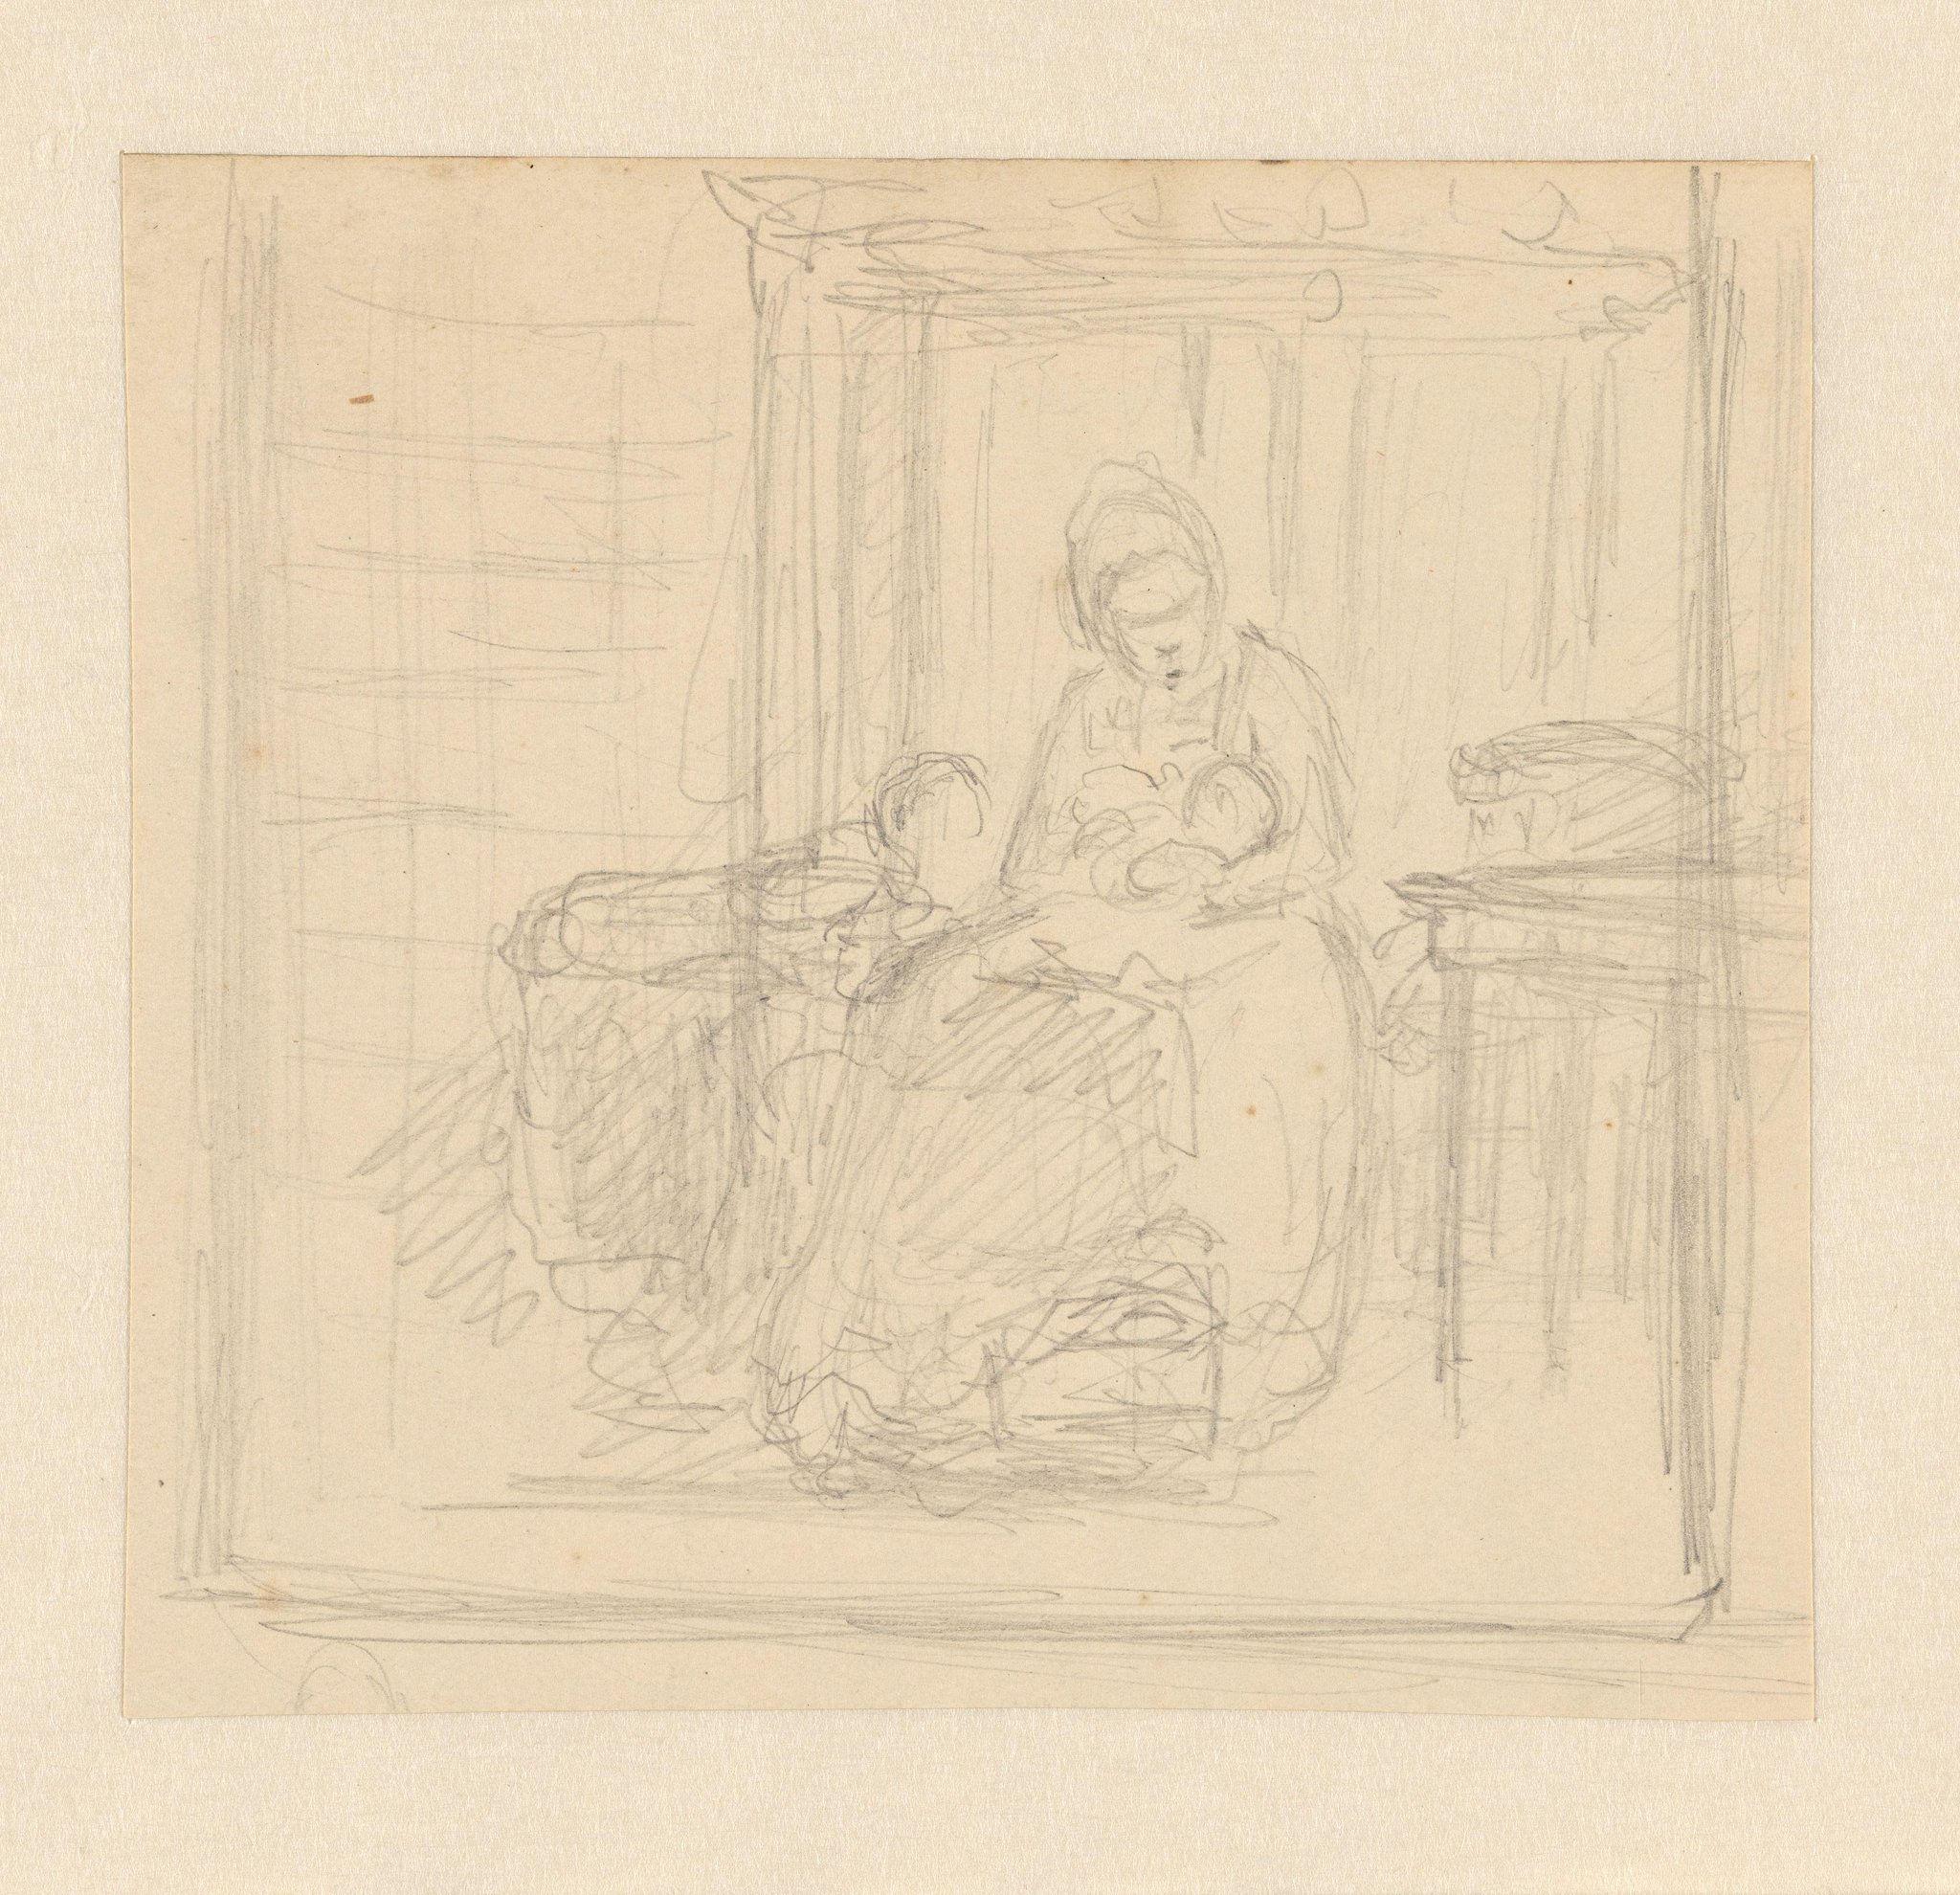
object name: drawing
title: Keukeninterieur met vrouw met kind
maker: hendrik valkenburg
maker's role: draughtsman, painter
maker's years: 1826-1896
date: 1836-1896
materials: paper, pencil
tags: corridor, mother and child(ren), woman and child(ren) (family group)